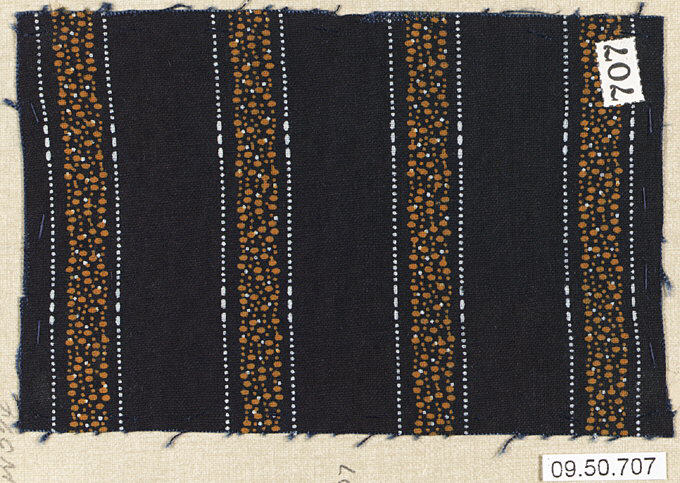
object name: piece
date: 1801-1900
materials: cotton